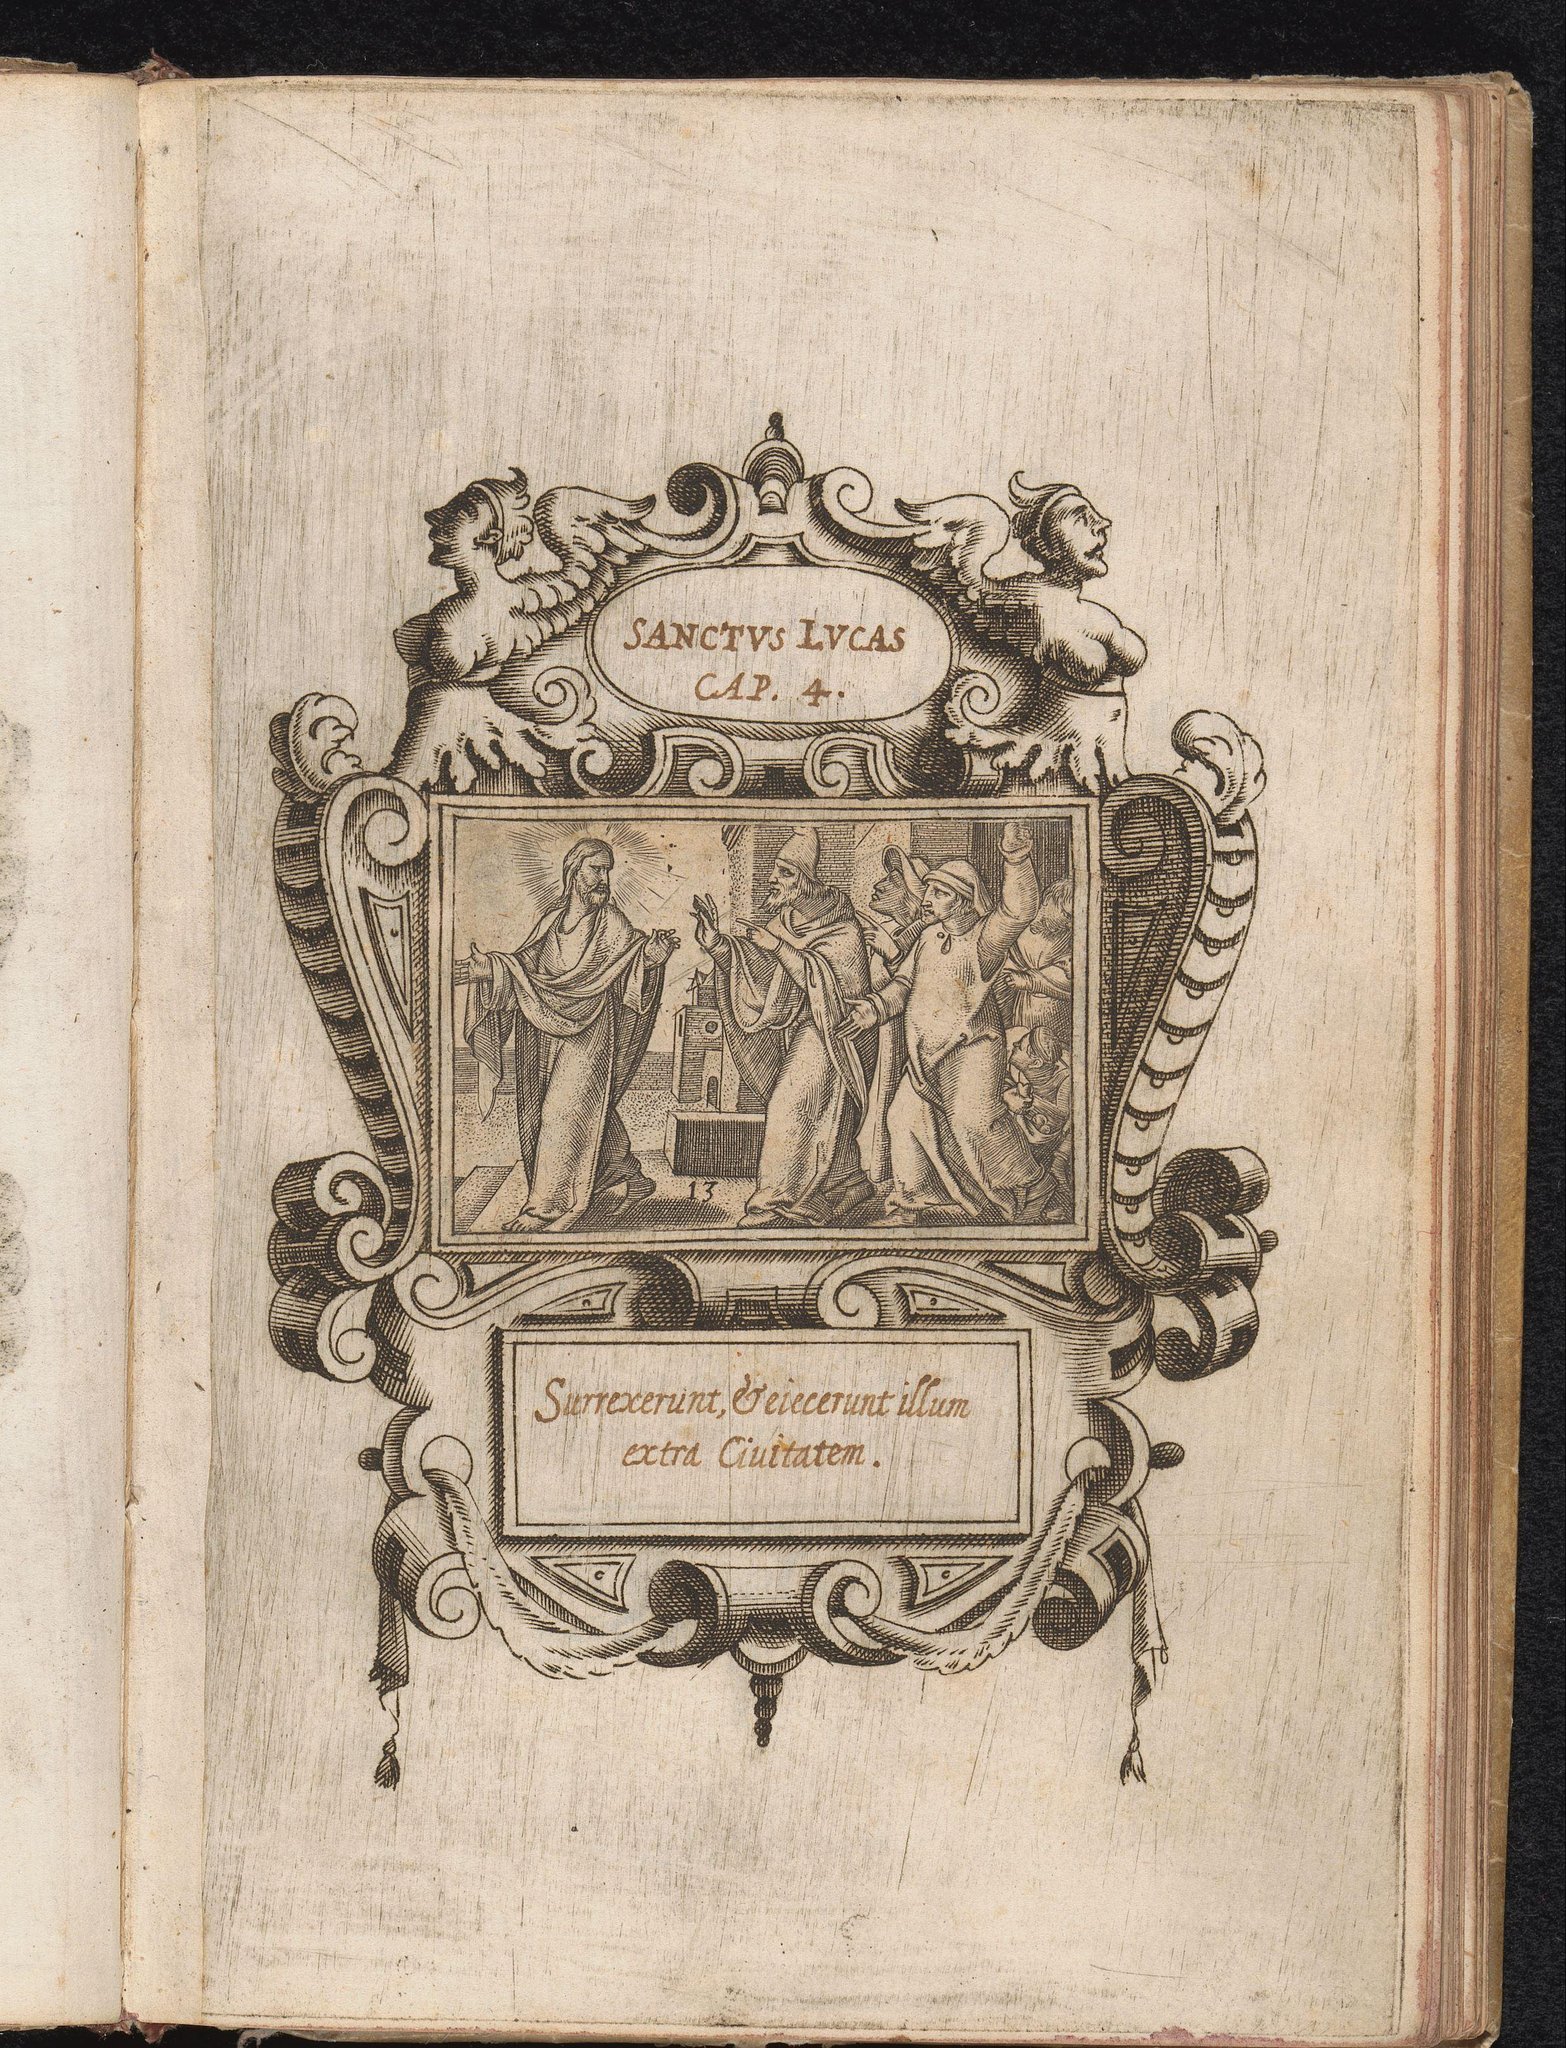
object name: print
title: Het leven van Christus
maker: Anonymous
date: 1570-1610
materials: paper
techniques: engraving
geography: germany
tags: attempts to stone christ (john 8:59, 10:31-33)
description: Poging om Christus te stenigen. Onderdeel van een prentalbum met titelprent en 56 scènes uit het Nieuwe Testament. Elke voorstelling gemonteerd in een gravure met ornamentele cartouches waarin een venster is gesneden en voorzien van handgeschreven bijbelpassages.